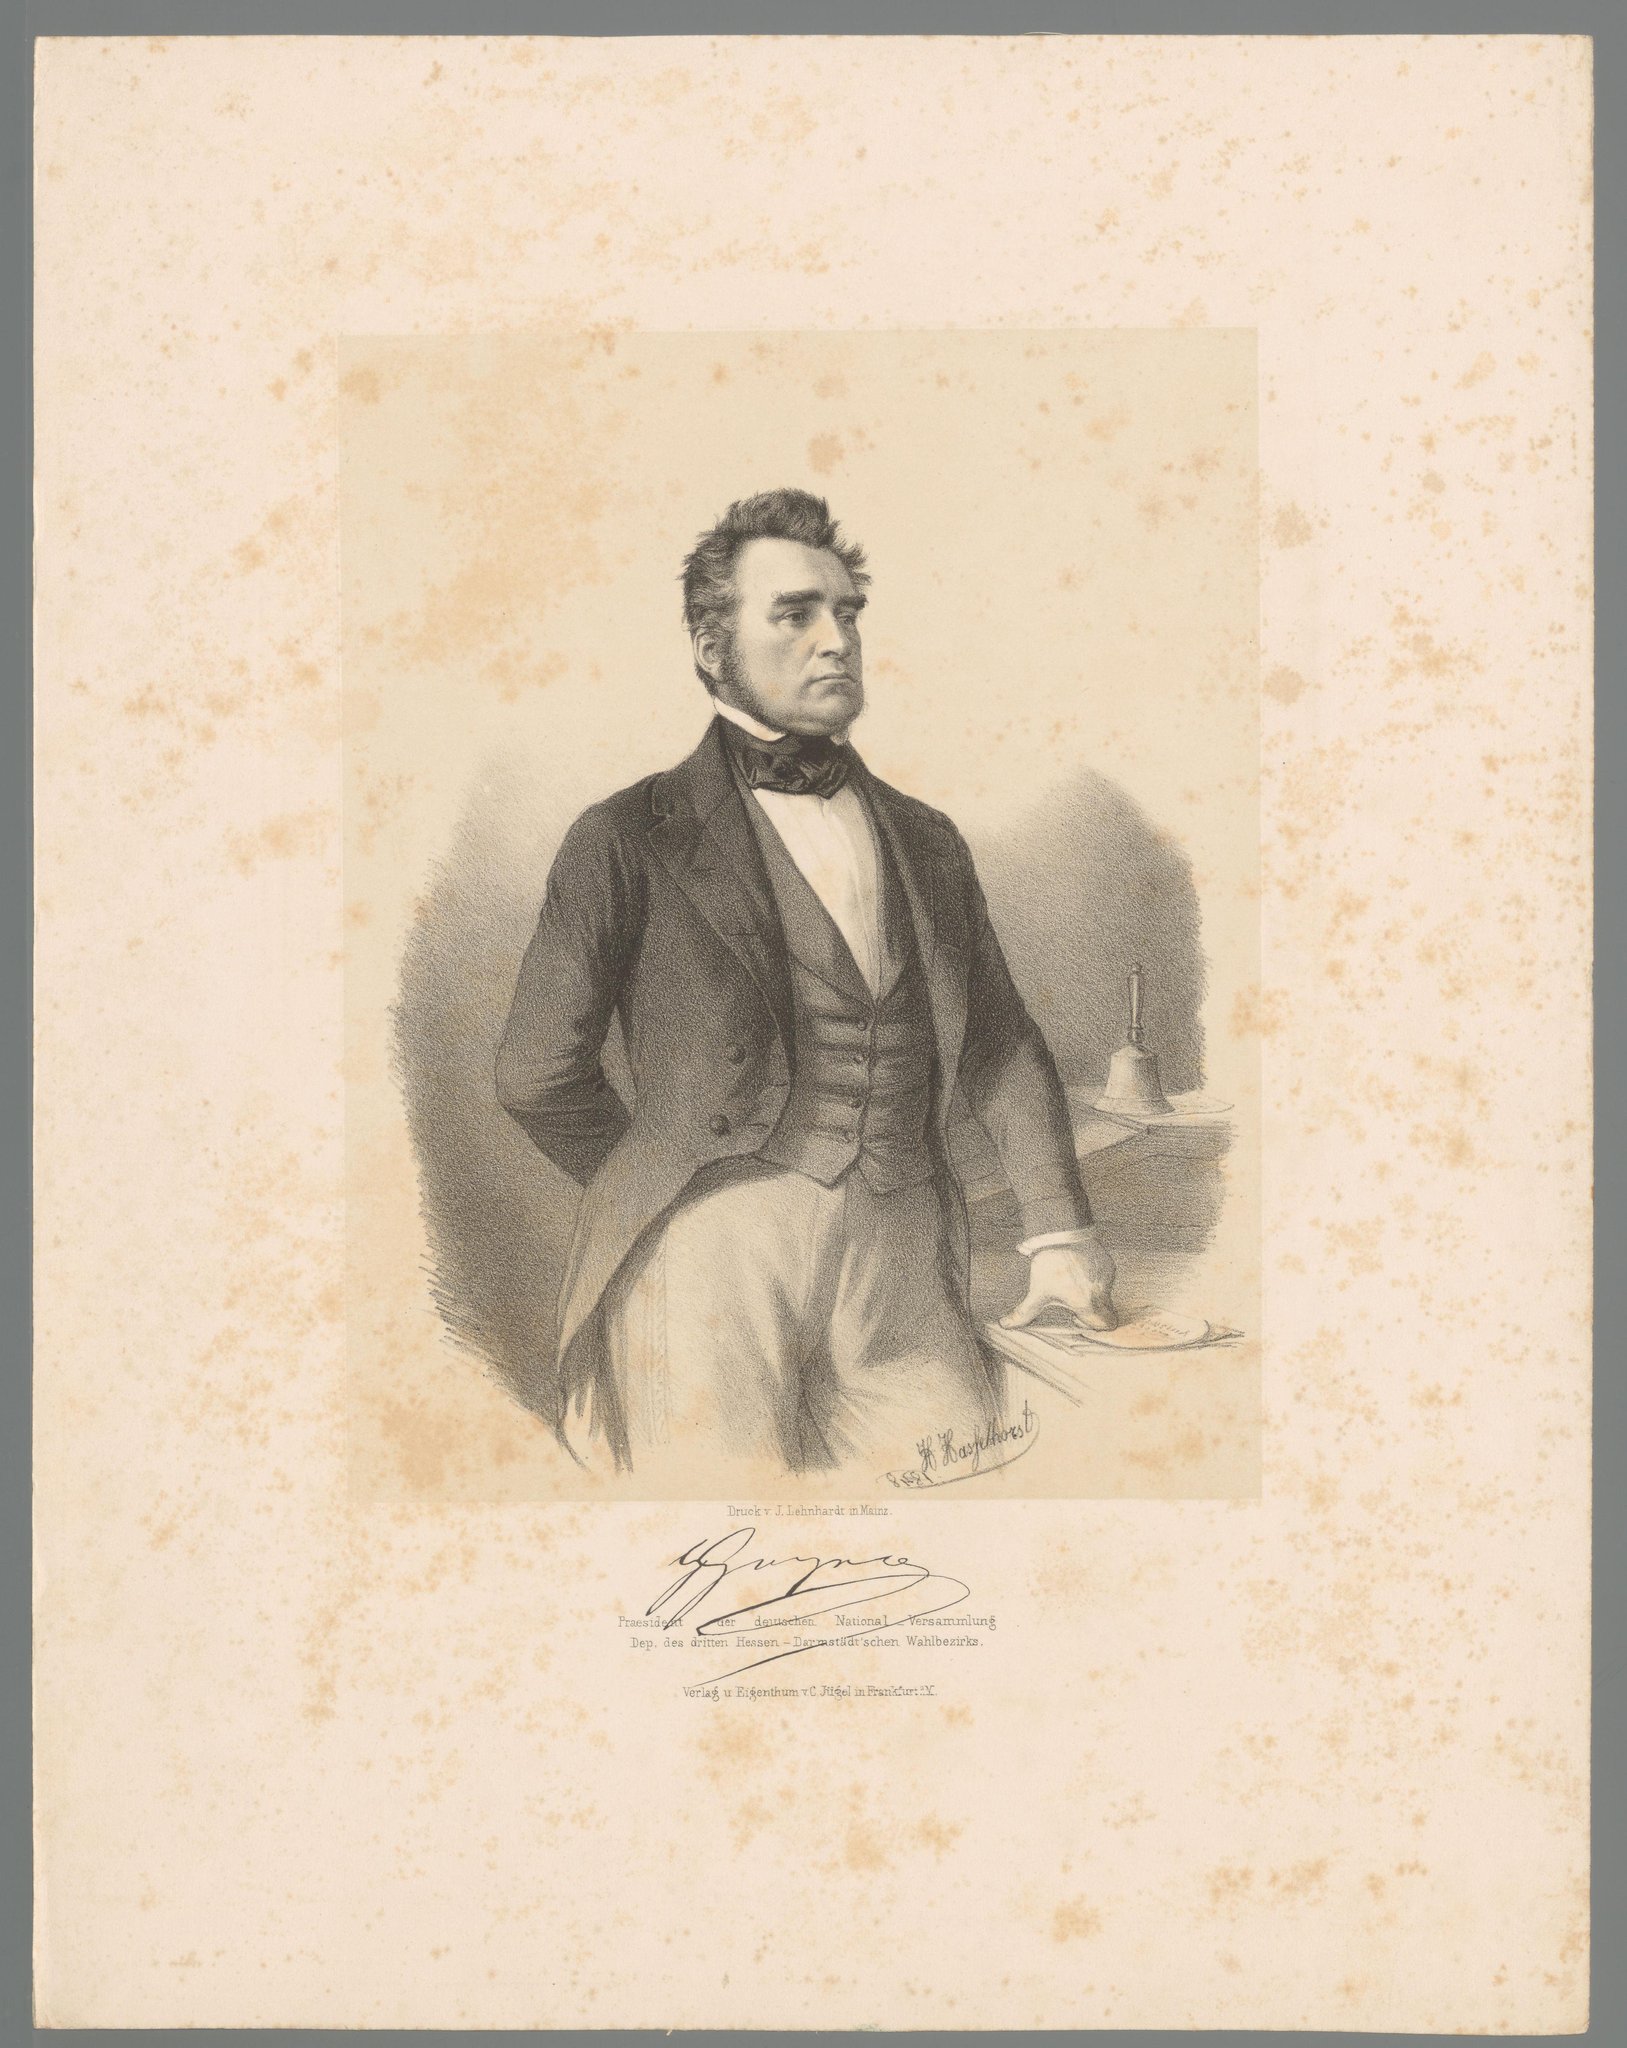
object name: print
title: Portret van Heinrich von Gagern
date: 1848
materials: paper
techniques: lithograph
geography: mainz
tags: historical persons, politician, e.g. party leader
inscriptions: collector's mark: Lugt 2228